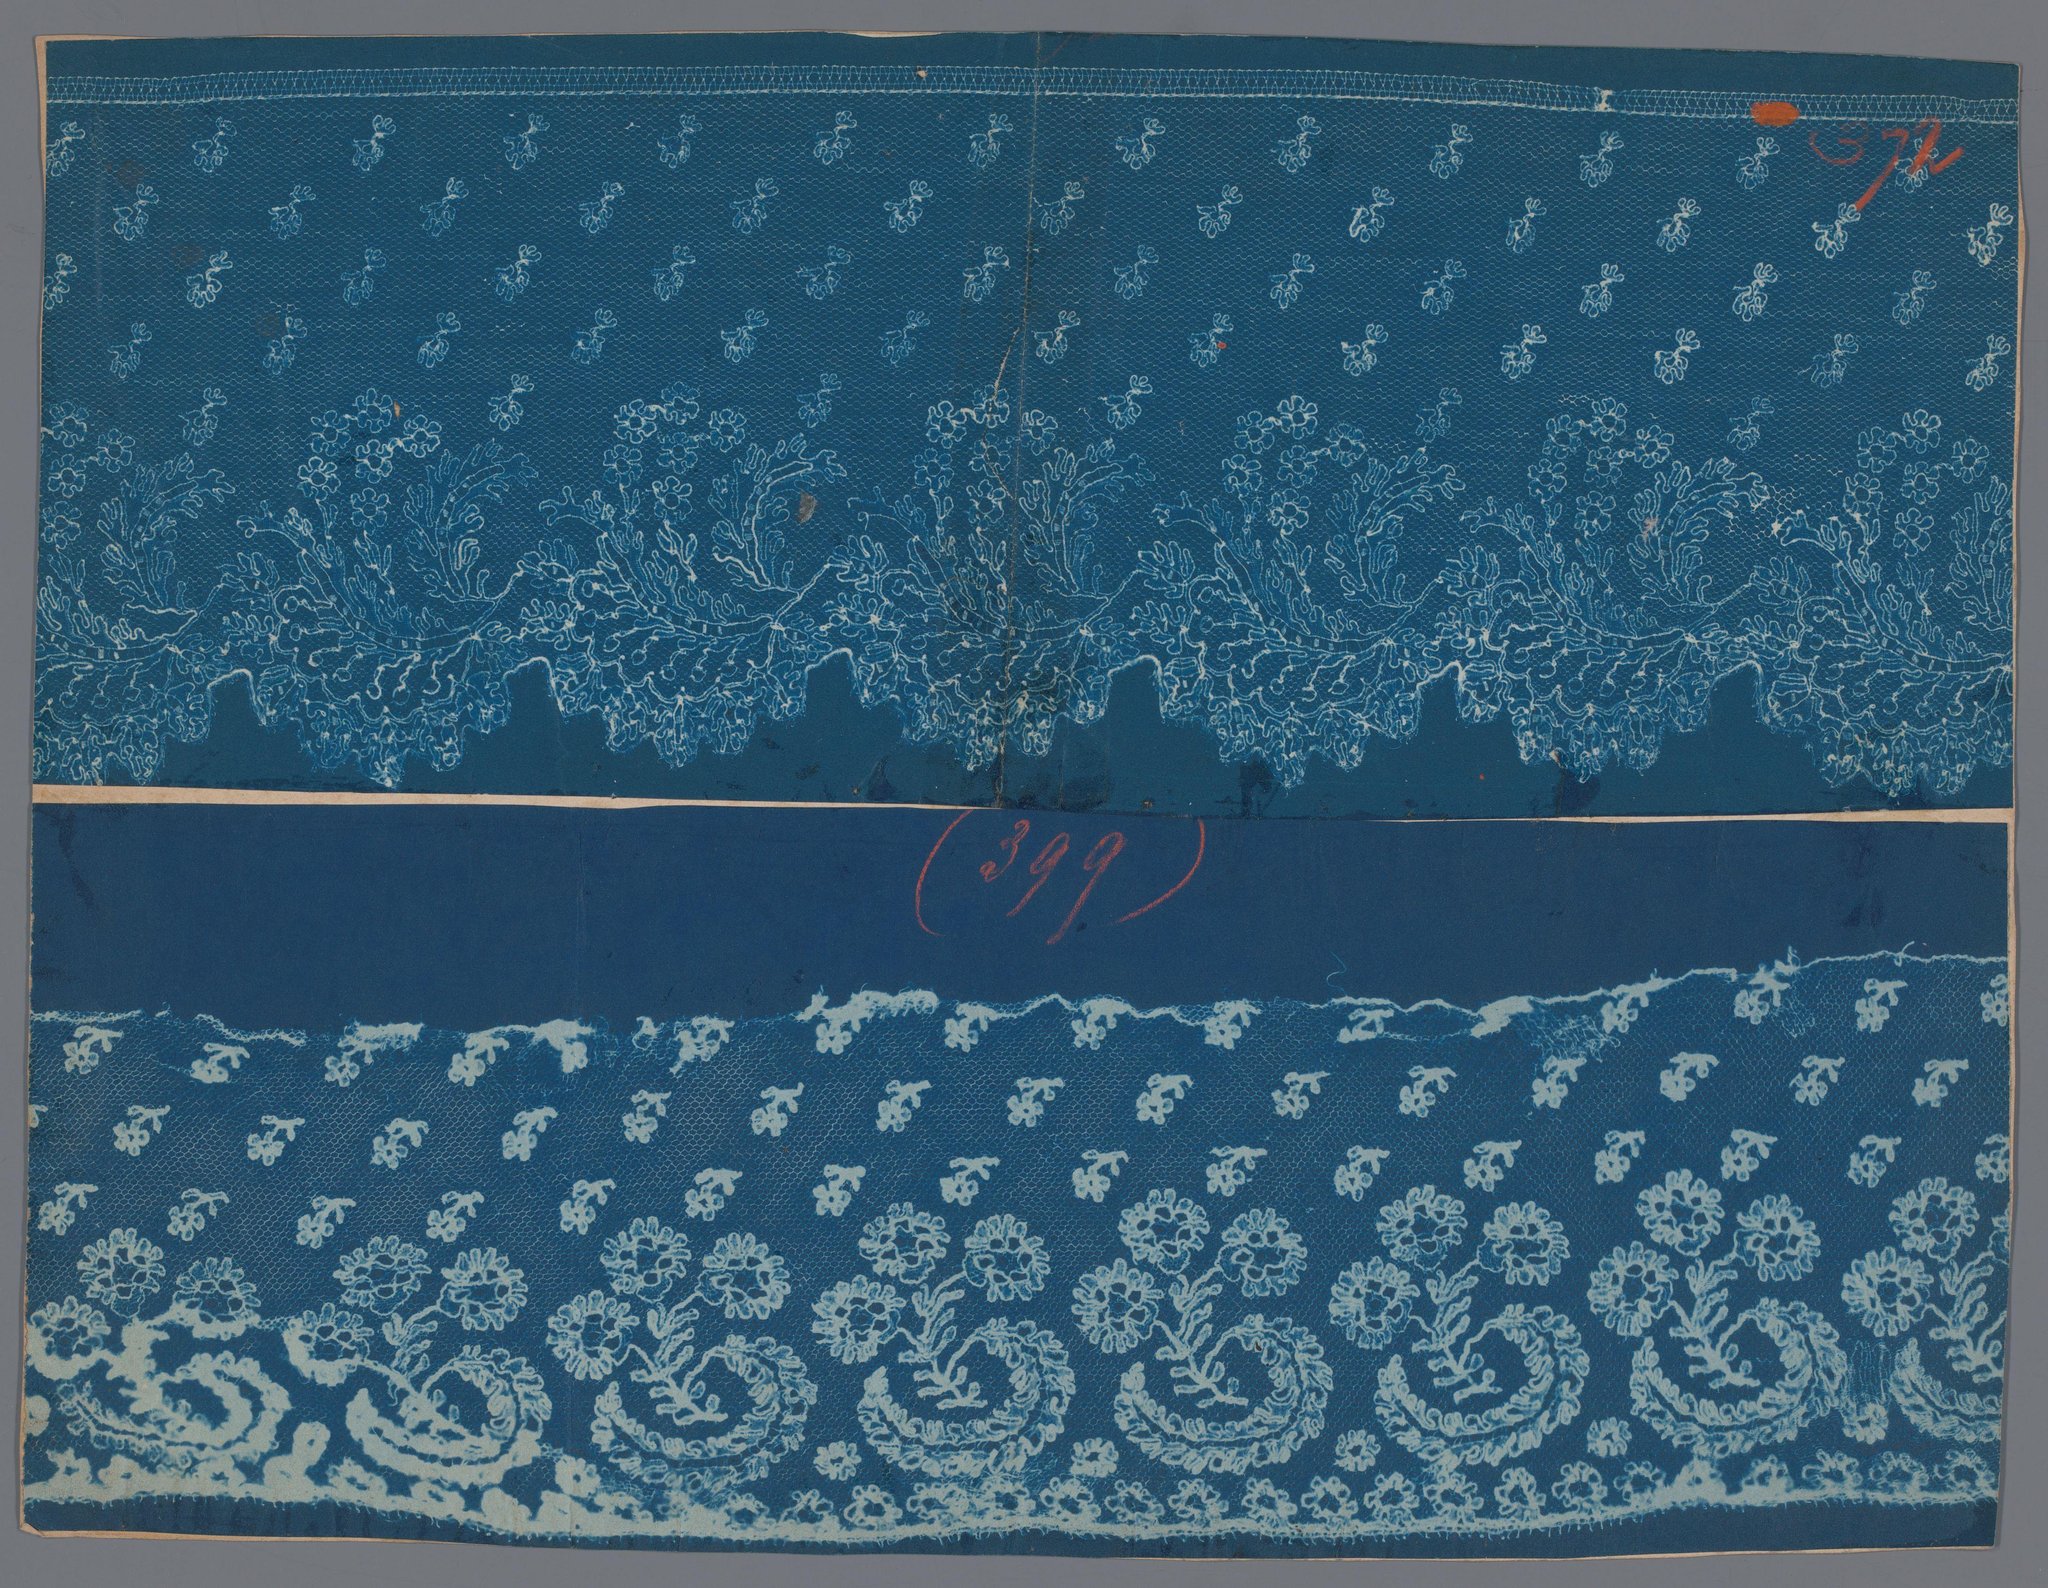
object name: photogram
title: Voorbeeld van kant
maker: Anonymous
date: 1890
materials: paper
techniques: cyanotype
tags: lace